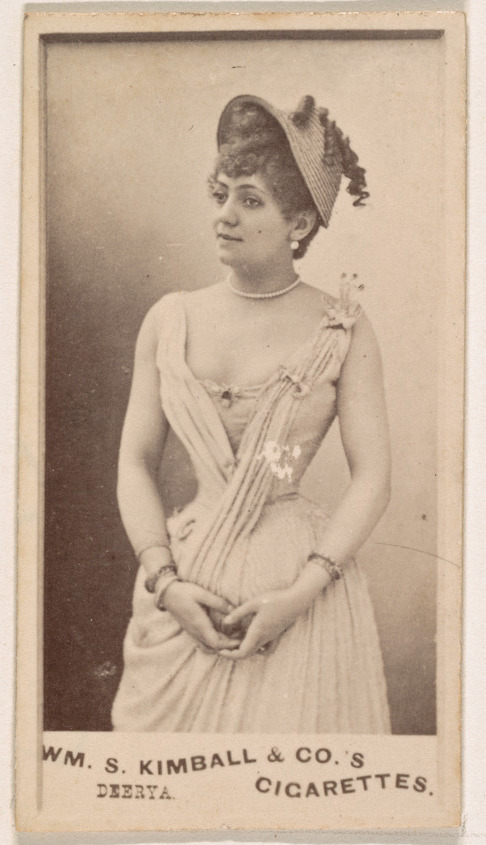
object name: photograph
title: Miss Deerya, from the Actresses series (N203) issued by Wm. S. Kimball & Co.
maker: william s. kimball & company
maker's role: publisher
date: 1889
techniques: color lithograph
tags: portraits,women,actresses